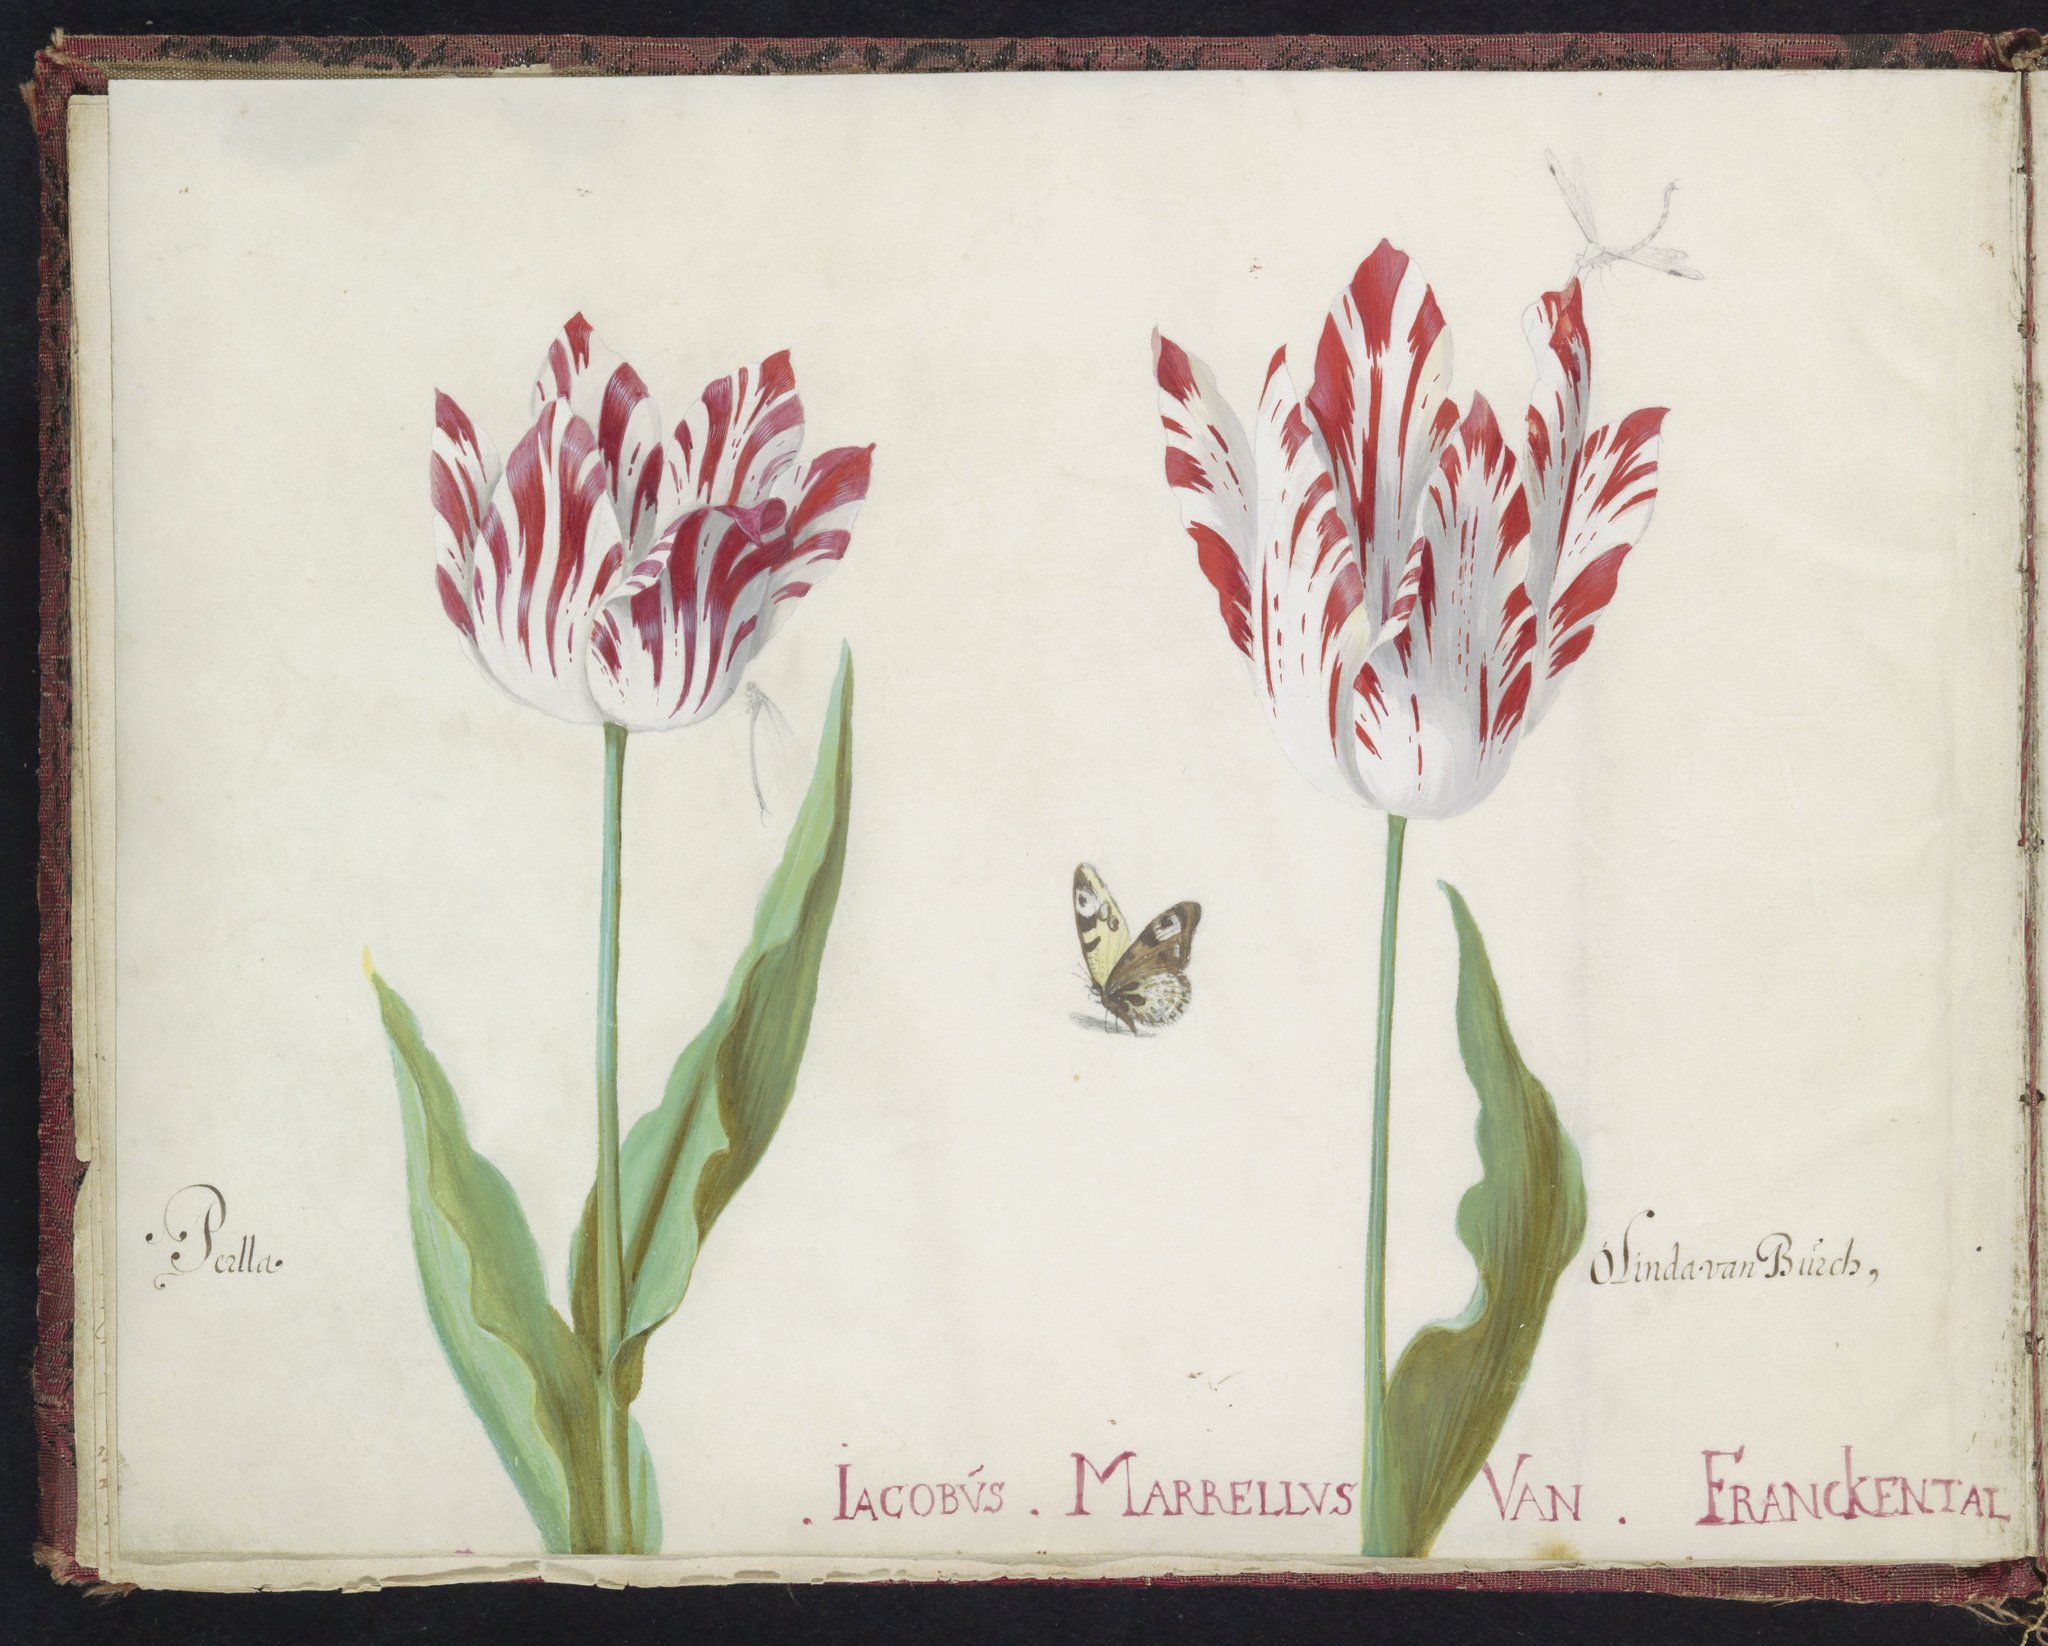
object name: drawing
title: Twee tulpen met vlinder en twee waterjuffers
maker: jacob marrel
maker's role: draughtsman, painter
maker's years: 1614-1681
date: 1637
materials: paint, parchment, pencil, watercolor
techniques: brush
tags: insects: dragon-fly, insects: butterfly, flowers: tulip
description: De tekening maakt deel uit van een album.